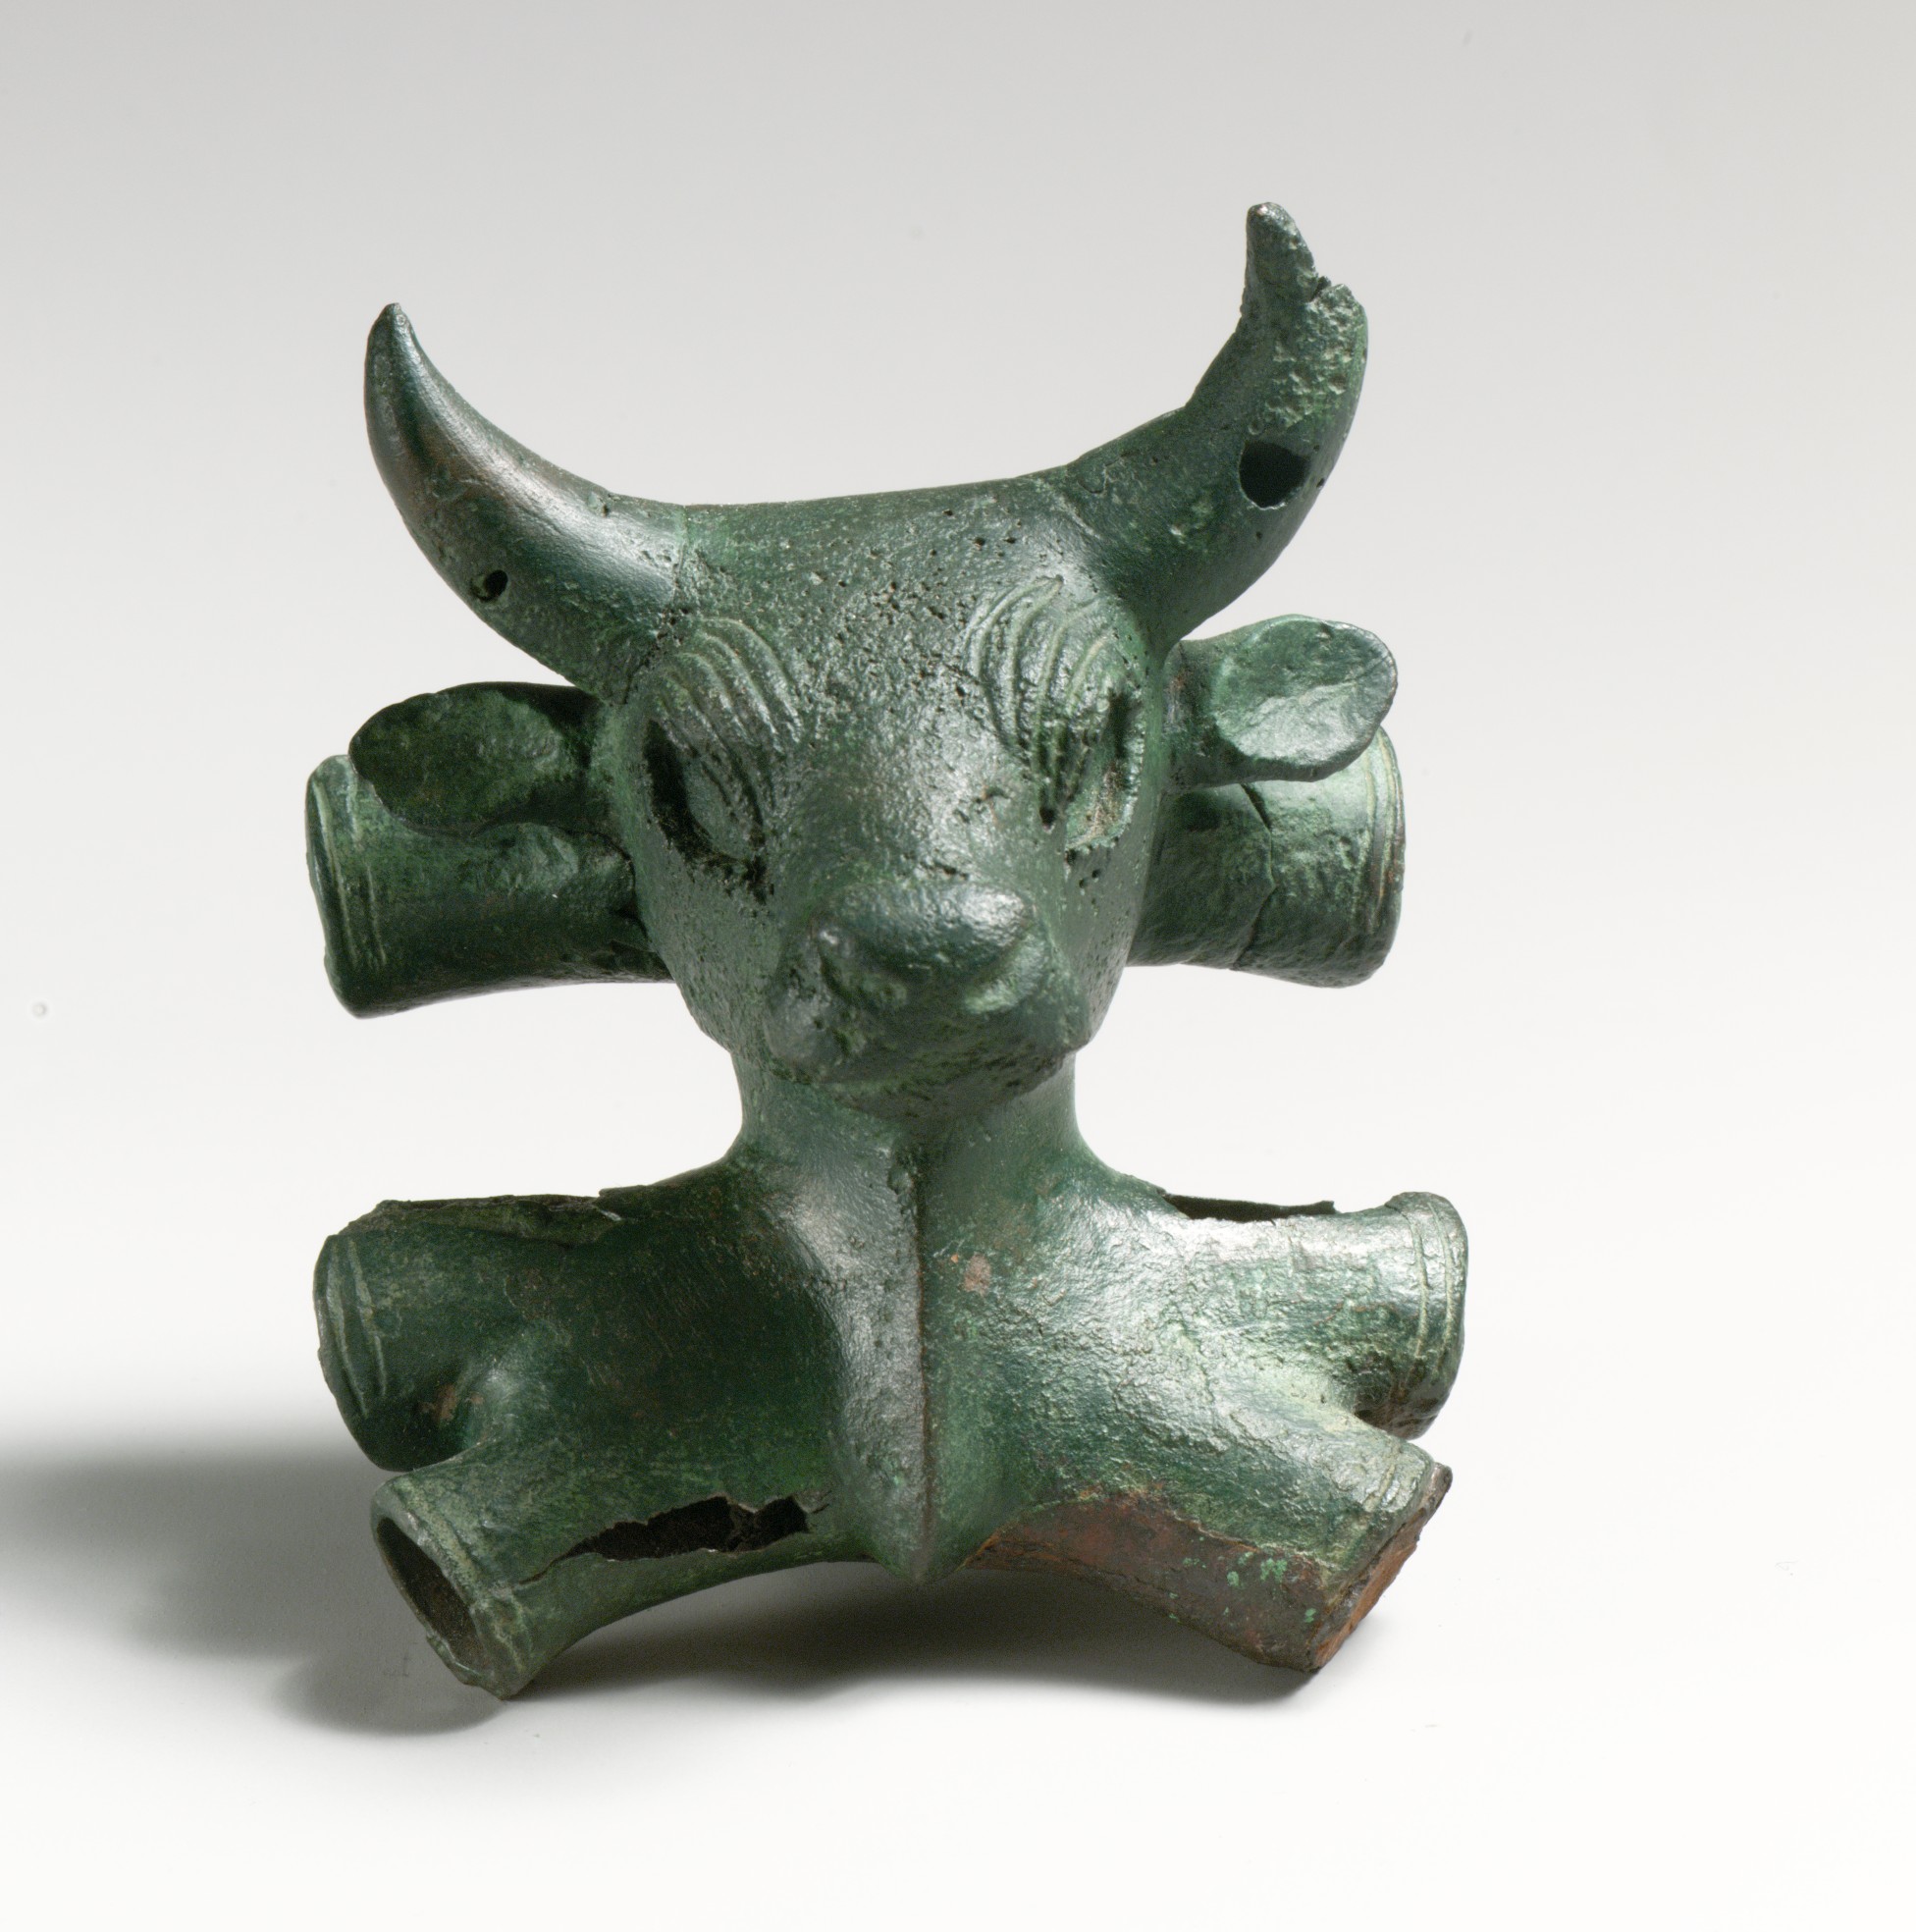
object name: attachment in the form of a bull's head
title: Bronze bull's head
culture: cypriot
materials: bronze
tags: bulls